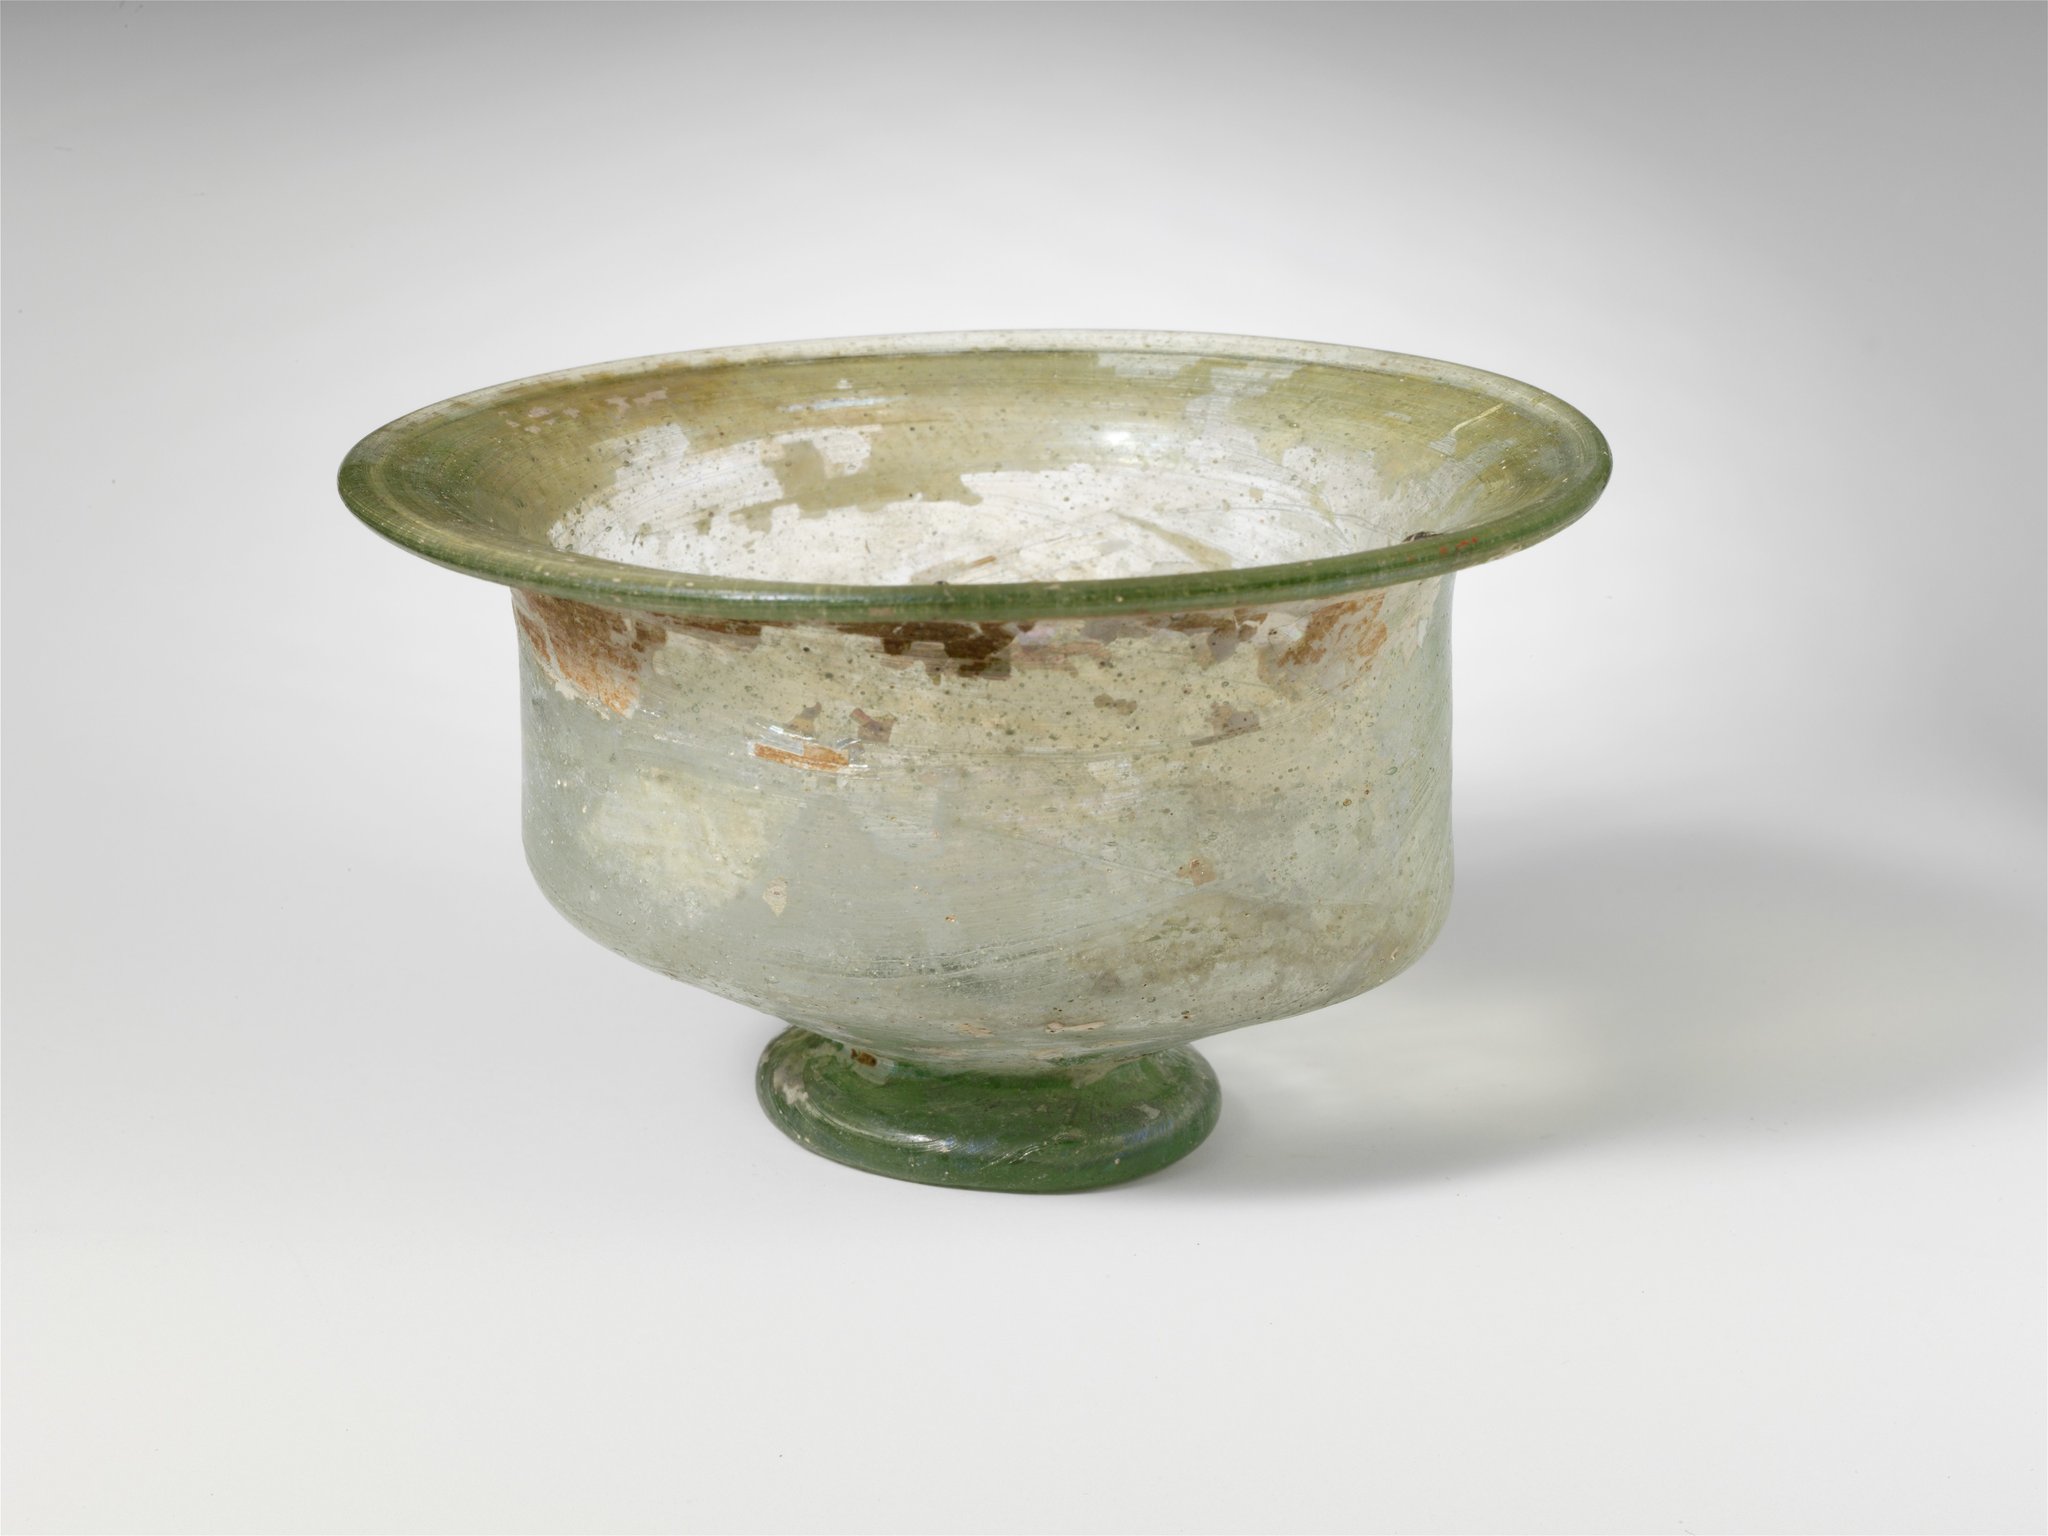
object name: bowl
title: Glass bowl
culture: roman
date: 101-300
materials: glass